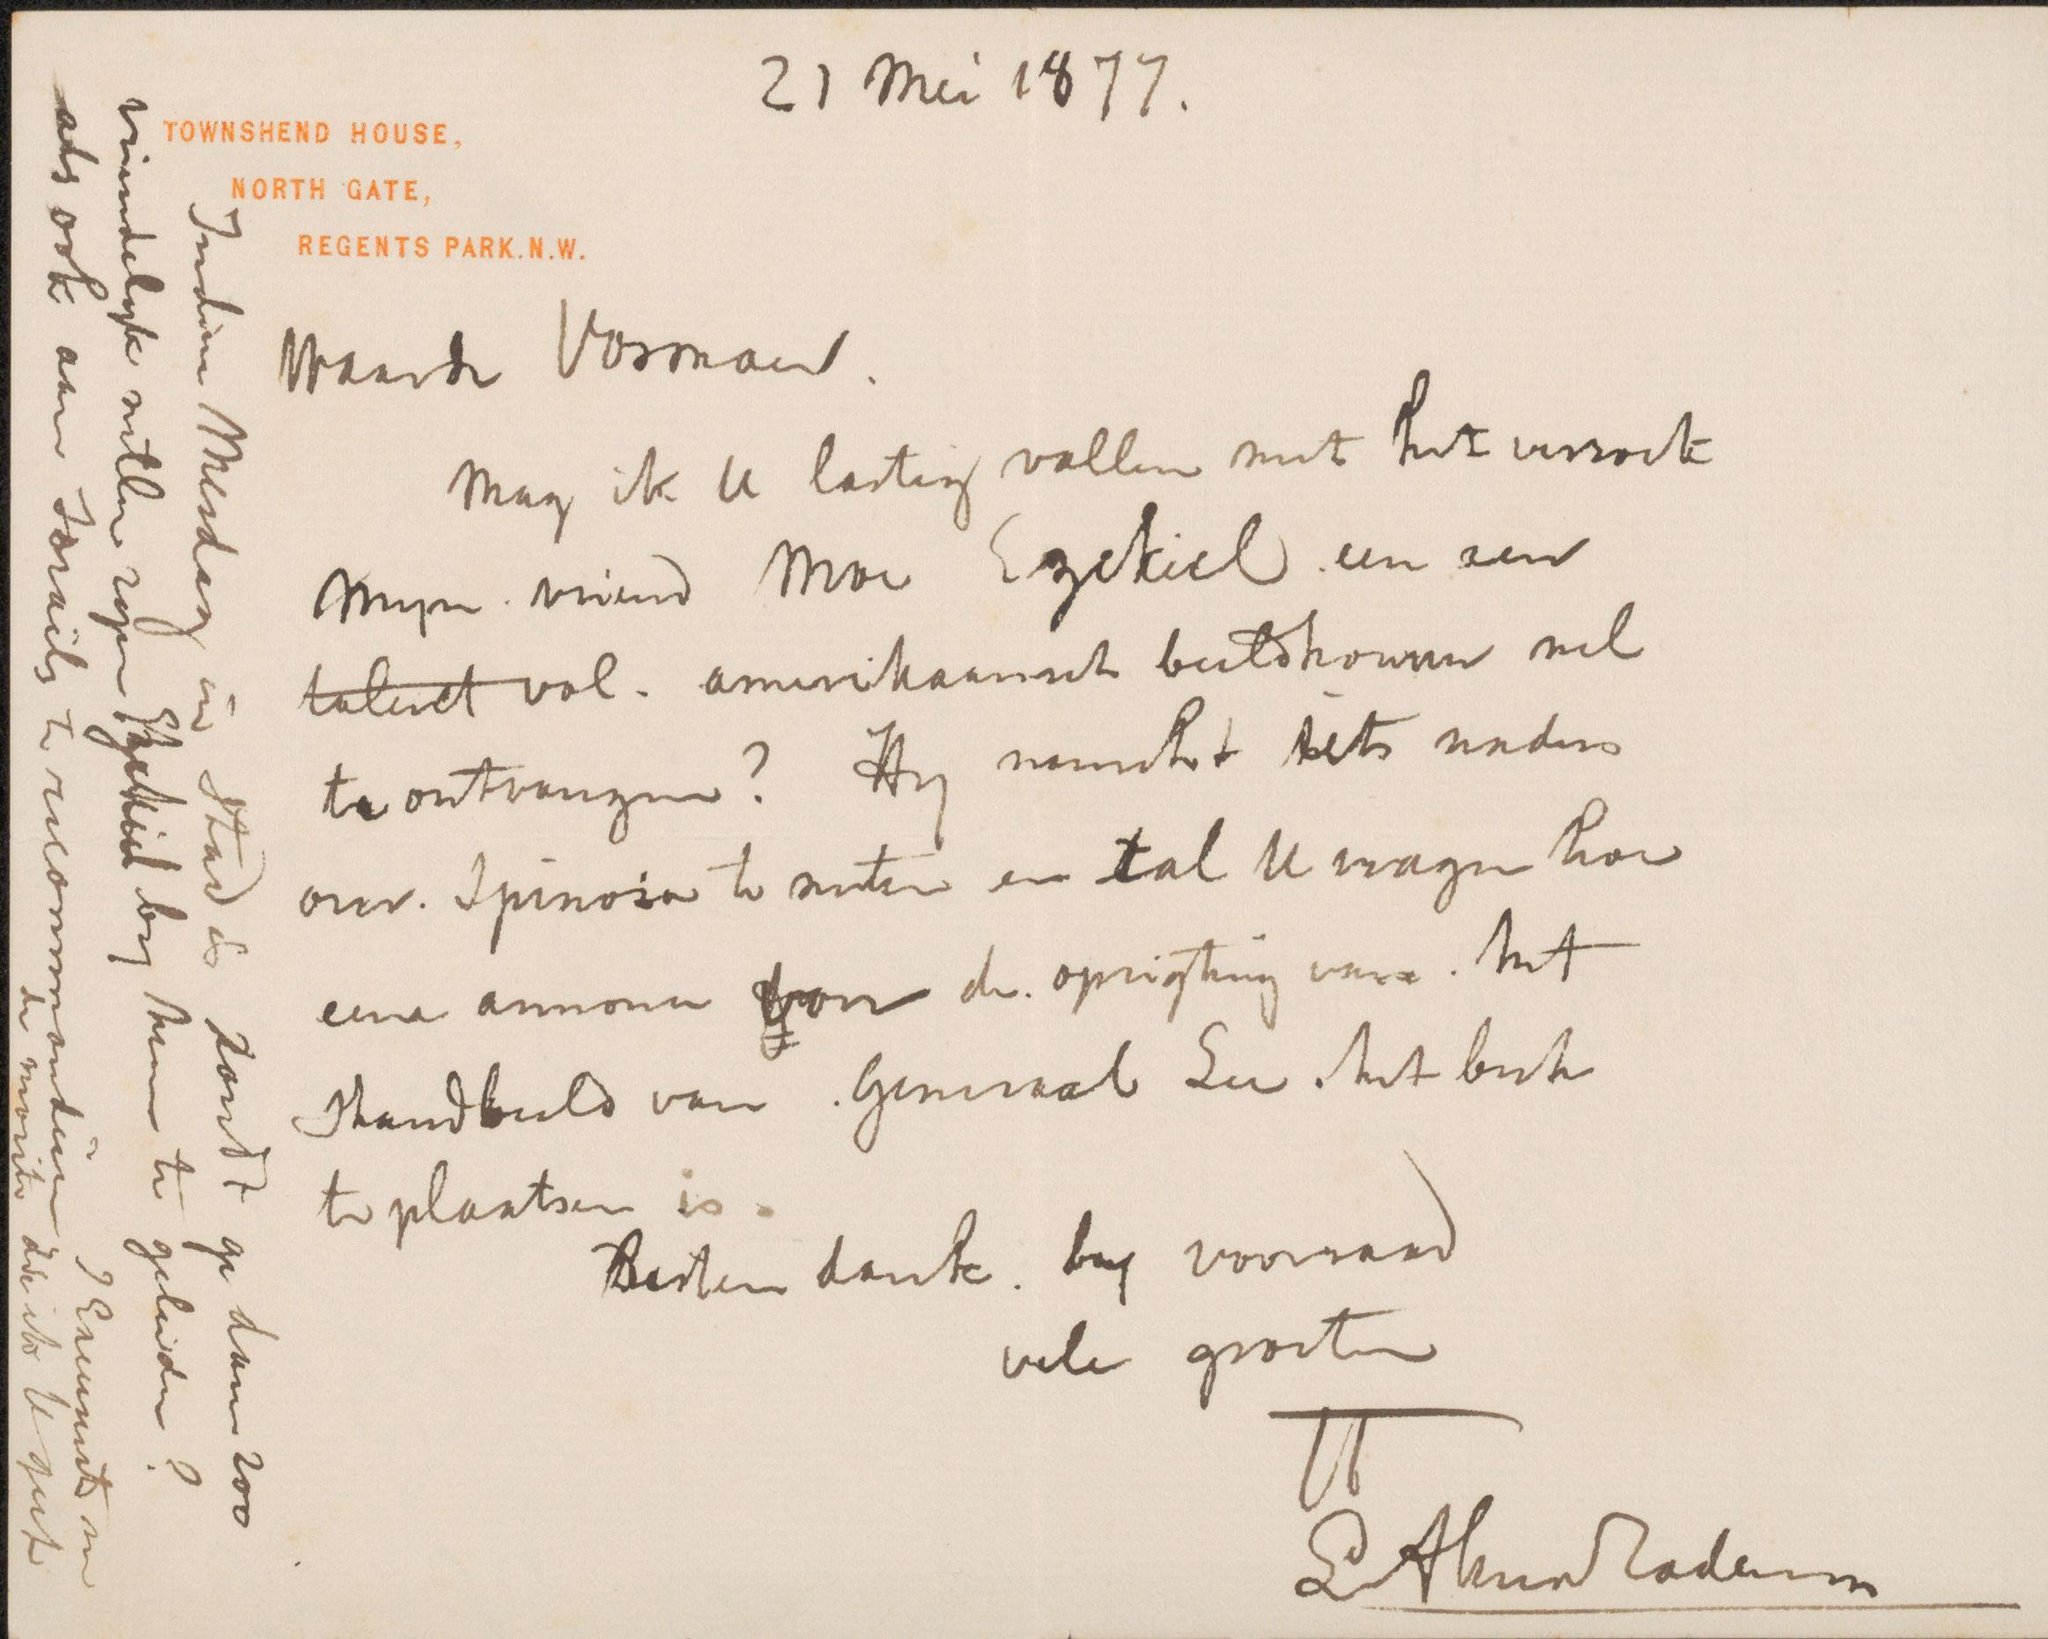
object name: letter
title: Brief aan Carel Vosmaer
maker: lourens alma tadema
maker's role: draughtsman, print maker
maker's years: 1836-1912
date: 1877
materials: ink, paper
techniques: pen, printing, writing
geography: london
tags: rome, sculptor, the hague, painter, jozef israëls, hendrik willem mesdag, carel vosmaer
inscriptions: watermark